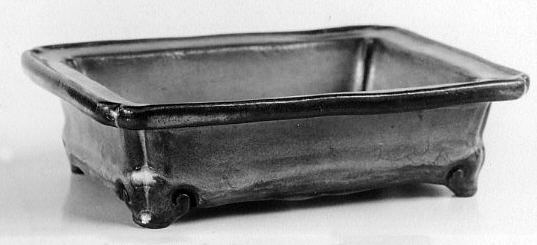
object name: dish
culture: chinese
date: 960-1279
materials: pottery